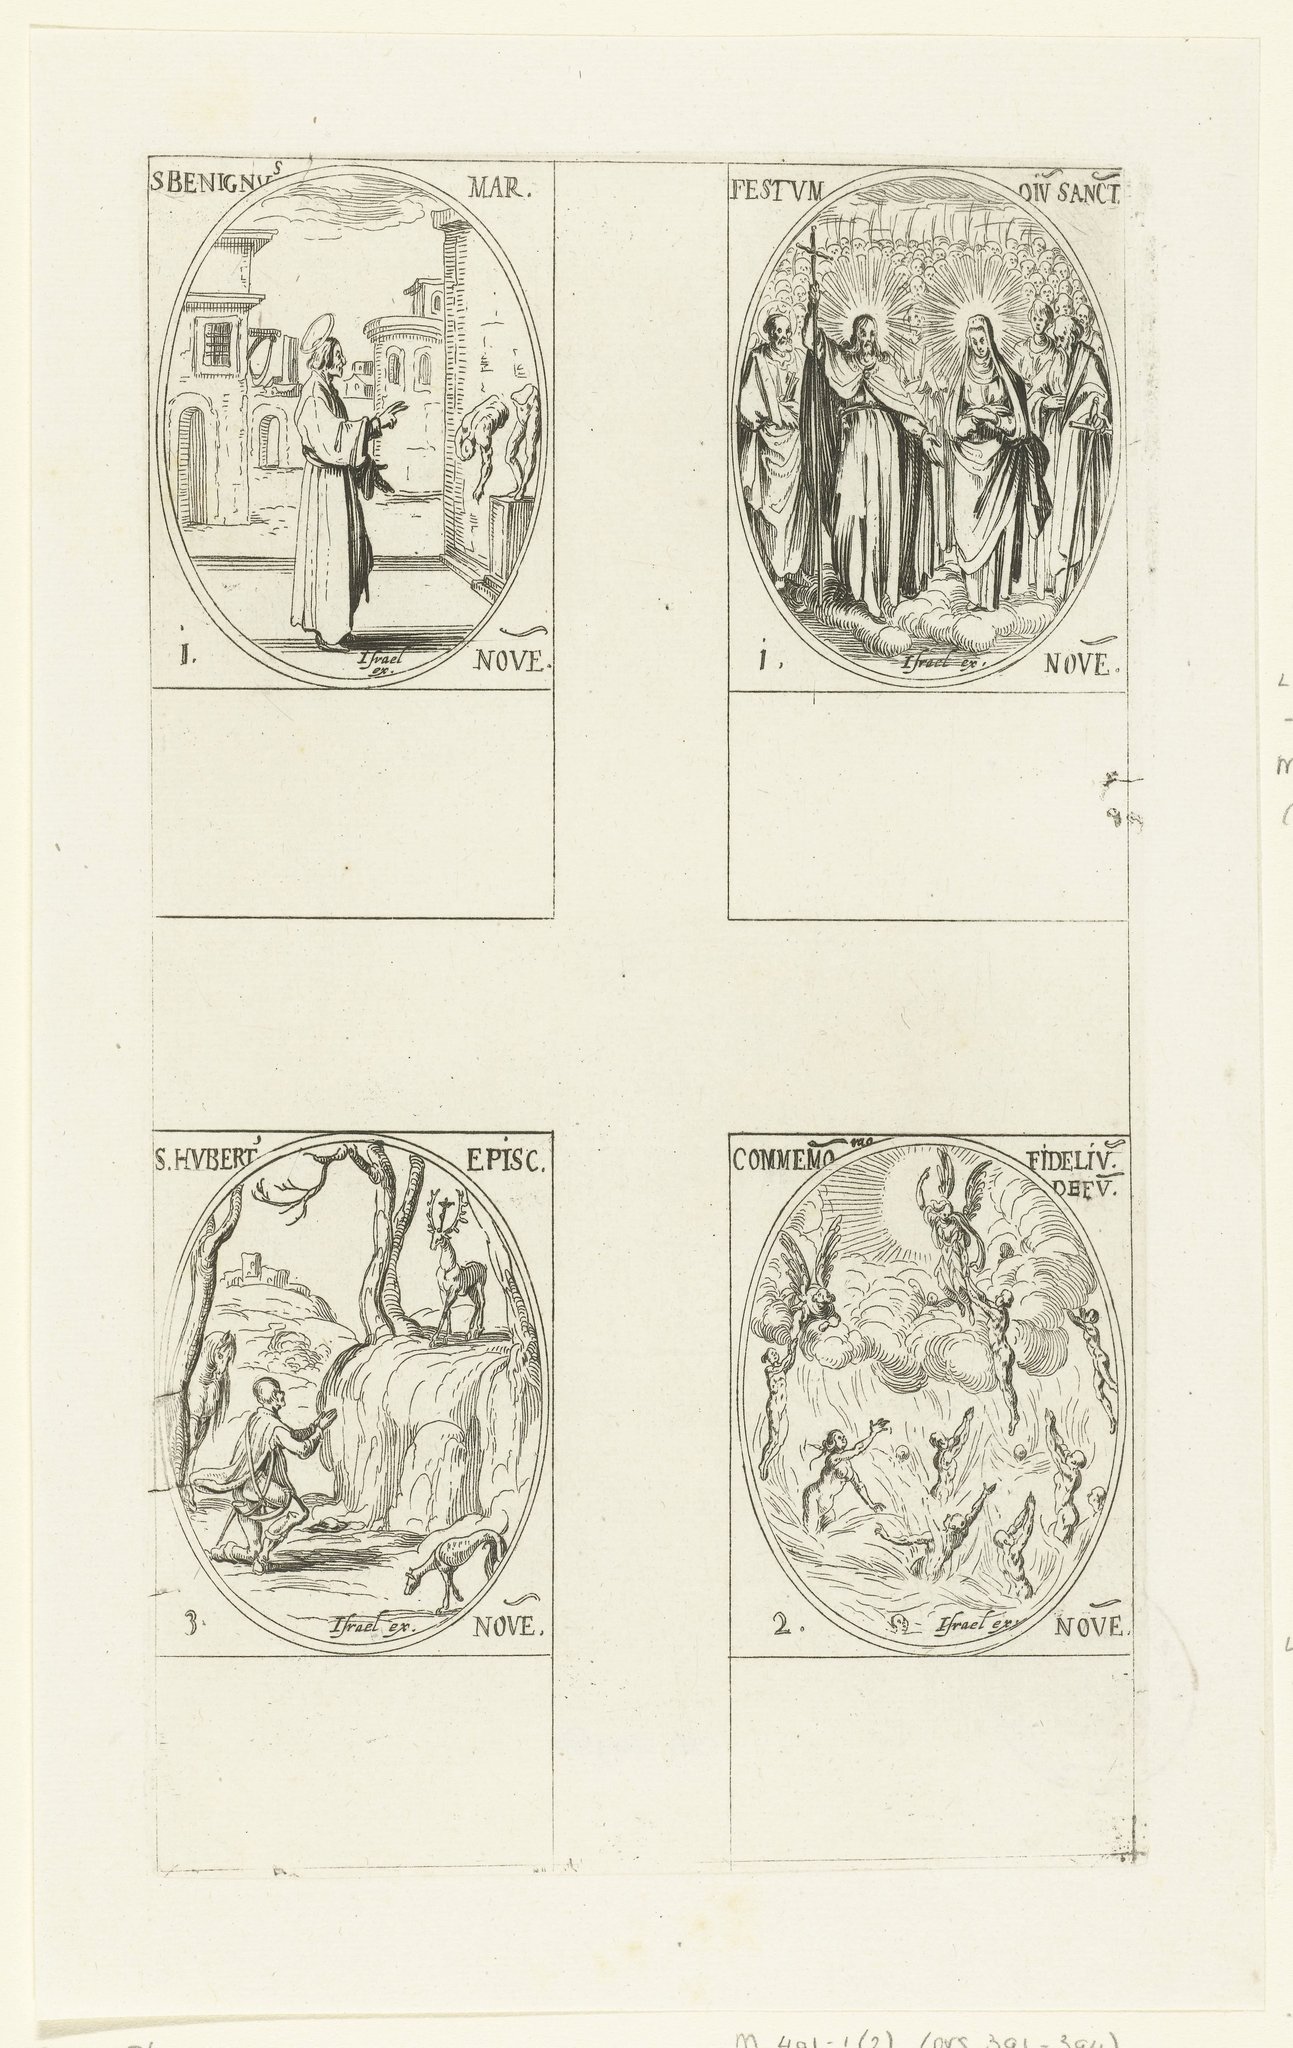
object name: print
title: Heilige Benignus van Dijon, Christus met Maria en vele heiligen (Allerheiligen), Engelen trekken zielen de hemel in (Allerzielen), Heilige Hubertus van Luik (1-3 november)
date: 1632-1636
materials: paper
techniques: etching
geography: nancy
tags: the hunter hubert(us), bishop of maastricht and liège; possible attributes: hounds, hunting horn, key, stag with crucifix, (bishop's) stole, all souls' day, all saints, 'all who are redeemed and now in heaven', male saints (with name)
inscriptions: collector's mark: Lugt 240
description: Blad met vier ovale voorstellingen, elk met opschrift en datum in het Latijn: linksboven de Heilige Benignus van Dijon die een heidens beeld kapot laat vallen, rechtsboven Christus met Maria en vele heiligen, rechtsonder engelen die zielen vanuit een vurige, helse plaats de hemel intrekken, linksonder de Heilige Hubertus die een crucifix in het gewei van een hert ziet. Deze prent is onderdeel van een serie prenten met voorstellingen van de heiligen en de christelijke feestdagen van het jaar. Er zijn steeds vier scènes van één plaat op één blad gedrukt. Inclusief bijbehorend titelblad en frontispice gaat het in totaal om 124 platen (490 voorstellingen). De drie platen met de laatste 12 scènes (de veranderlijke christelijke feestdagen) zijn in de derde staat versneden tot 12 kleine plaatjes, en met een apart titelblad uitgegeven.